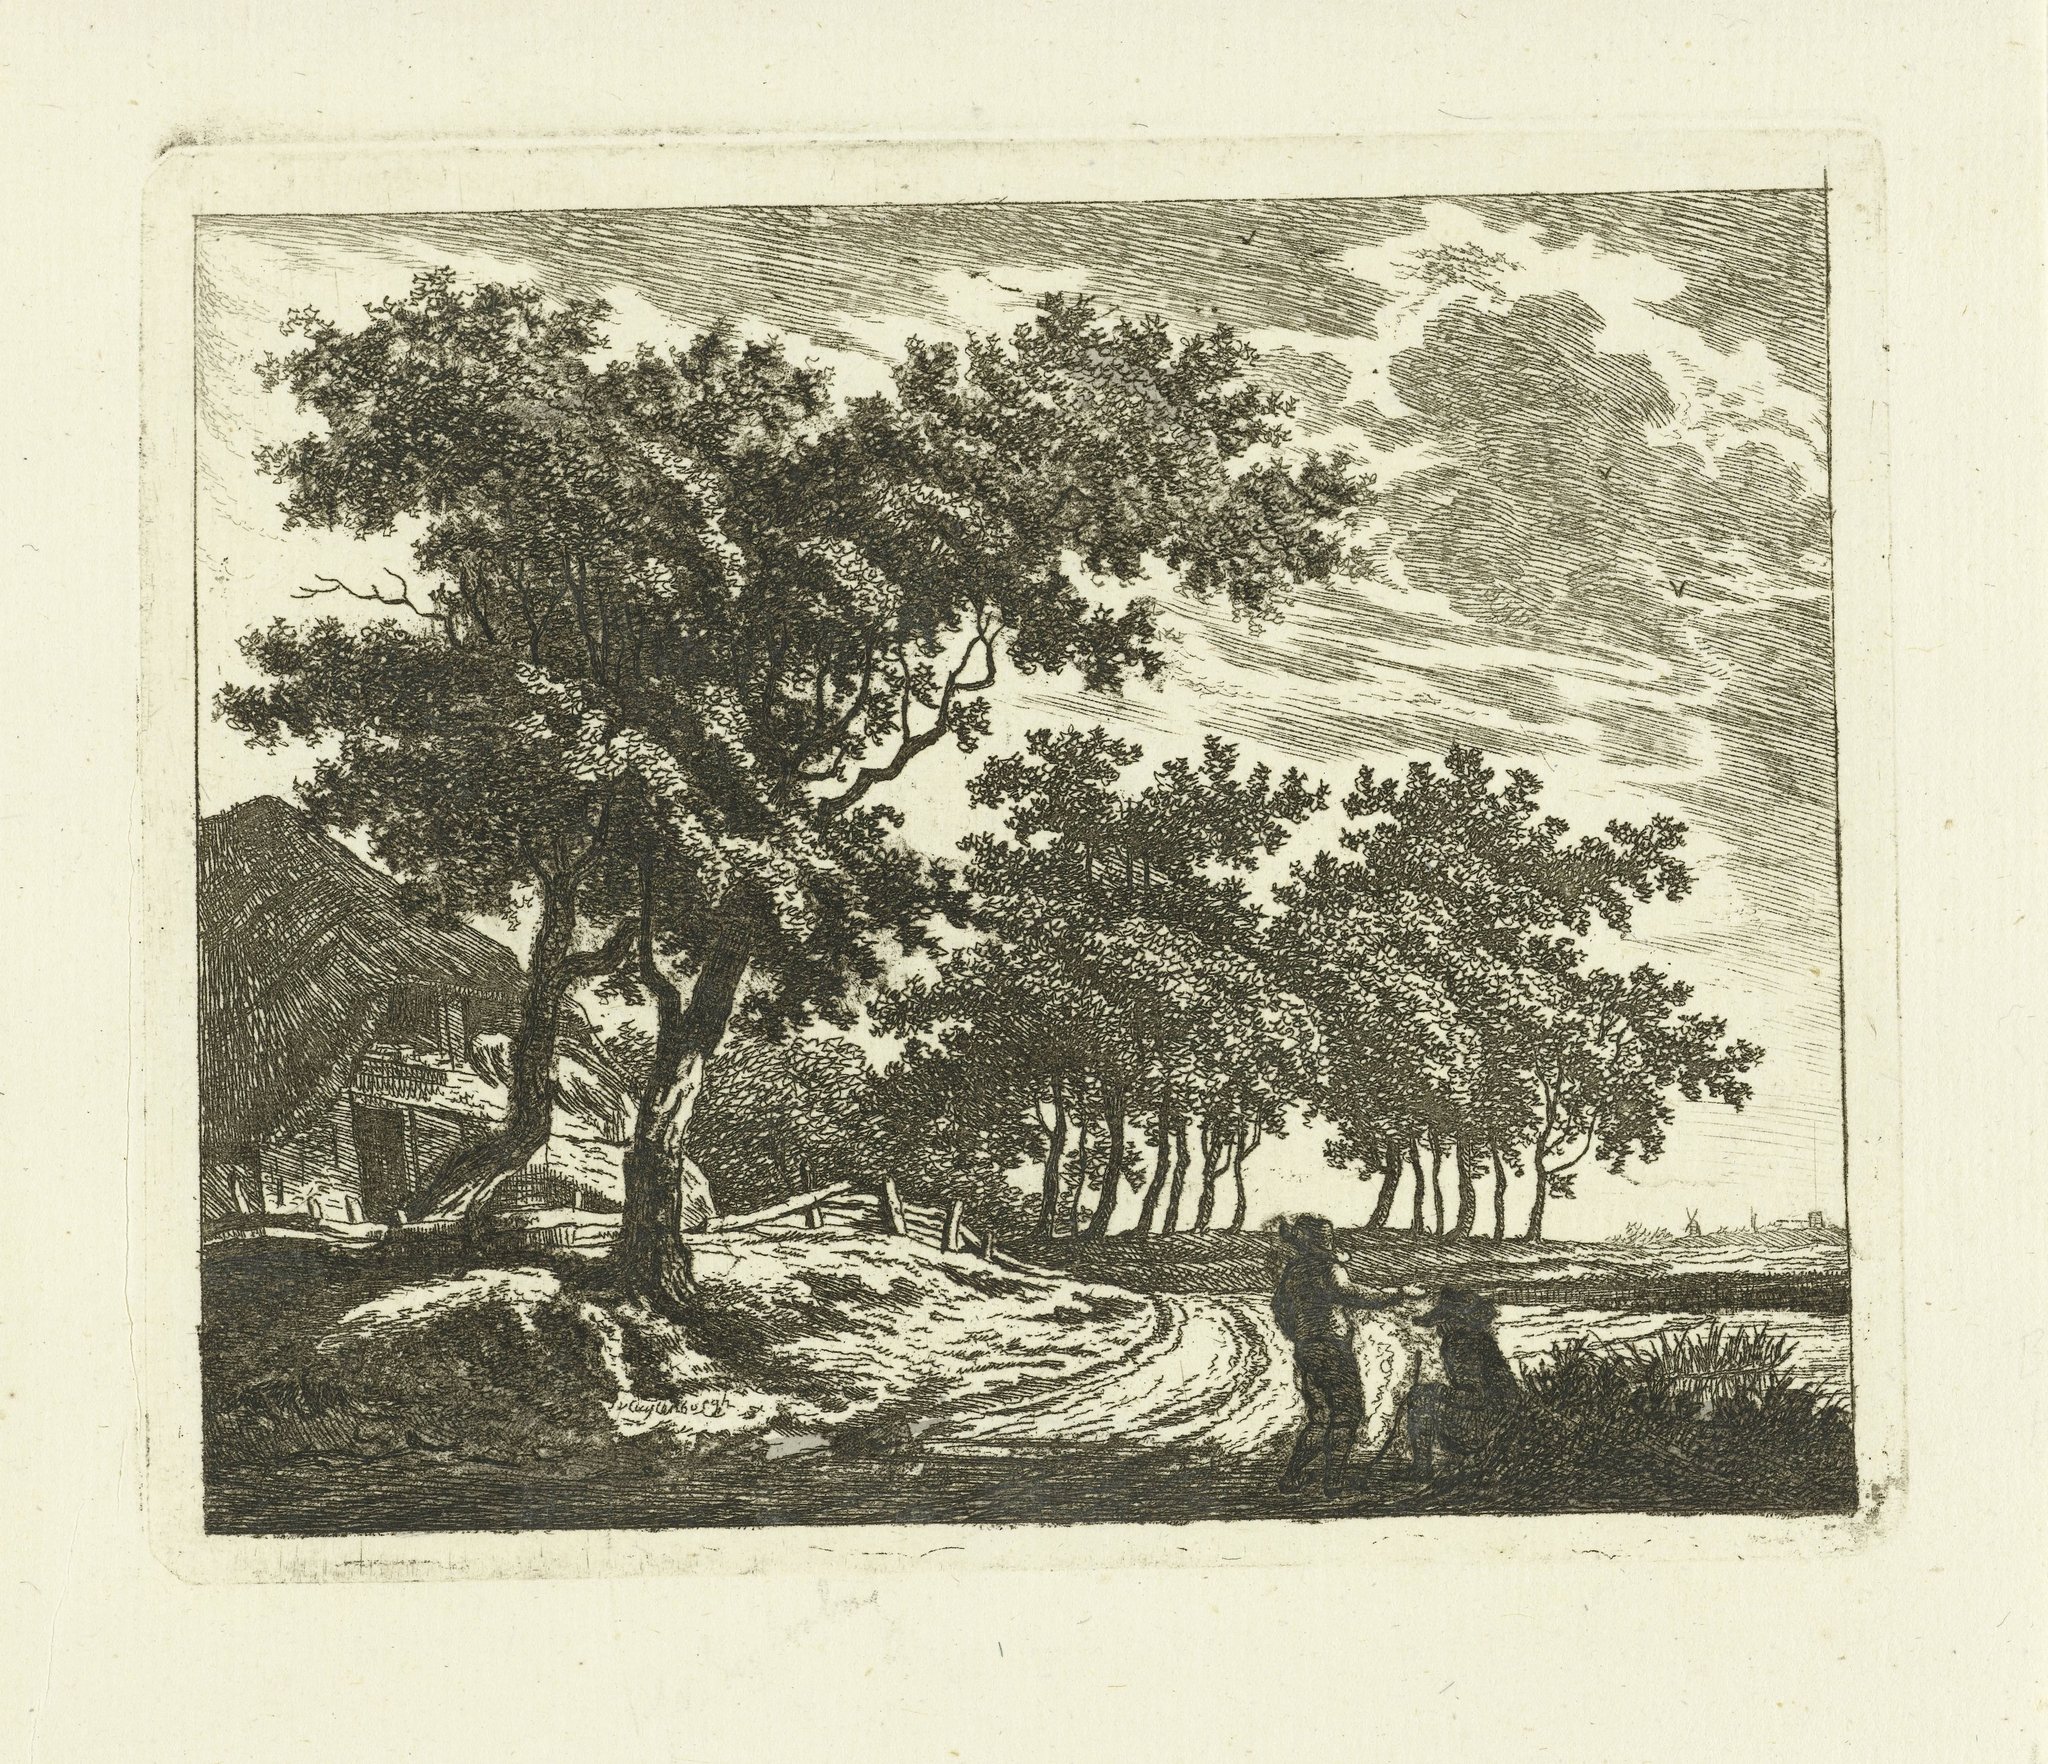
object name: print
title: Landschap met boerderij aan zandweg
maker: johannes van cuylenburgh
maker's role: print maker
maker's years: 1793-1841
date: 1803-1841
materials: paper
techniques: etching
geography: netherlands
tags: farm or solitary house in landscape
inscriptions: collector's mark: Lugt 2228